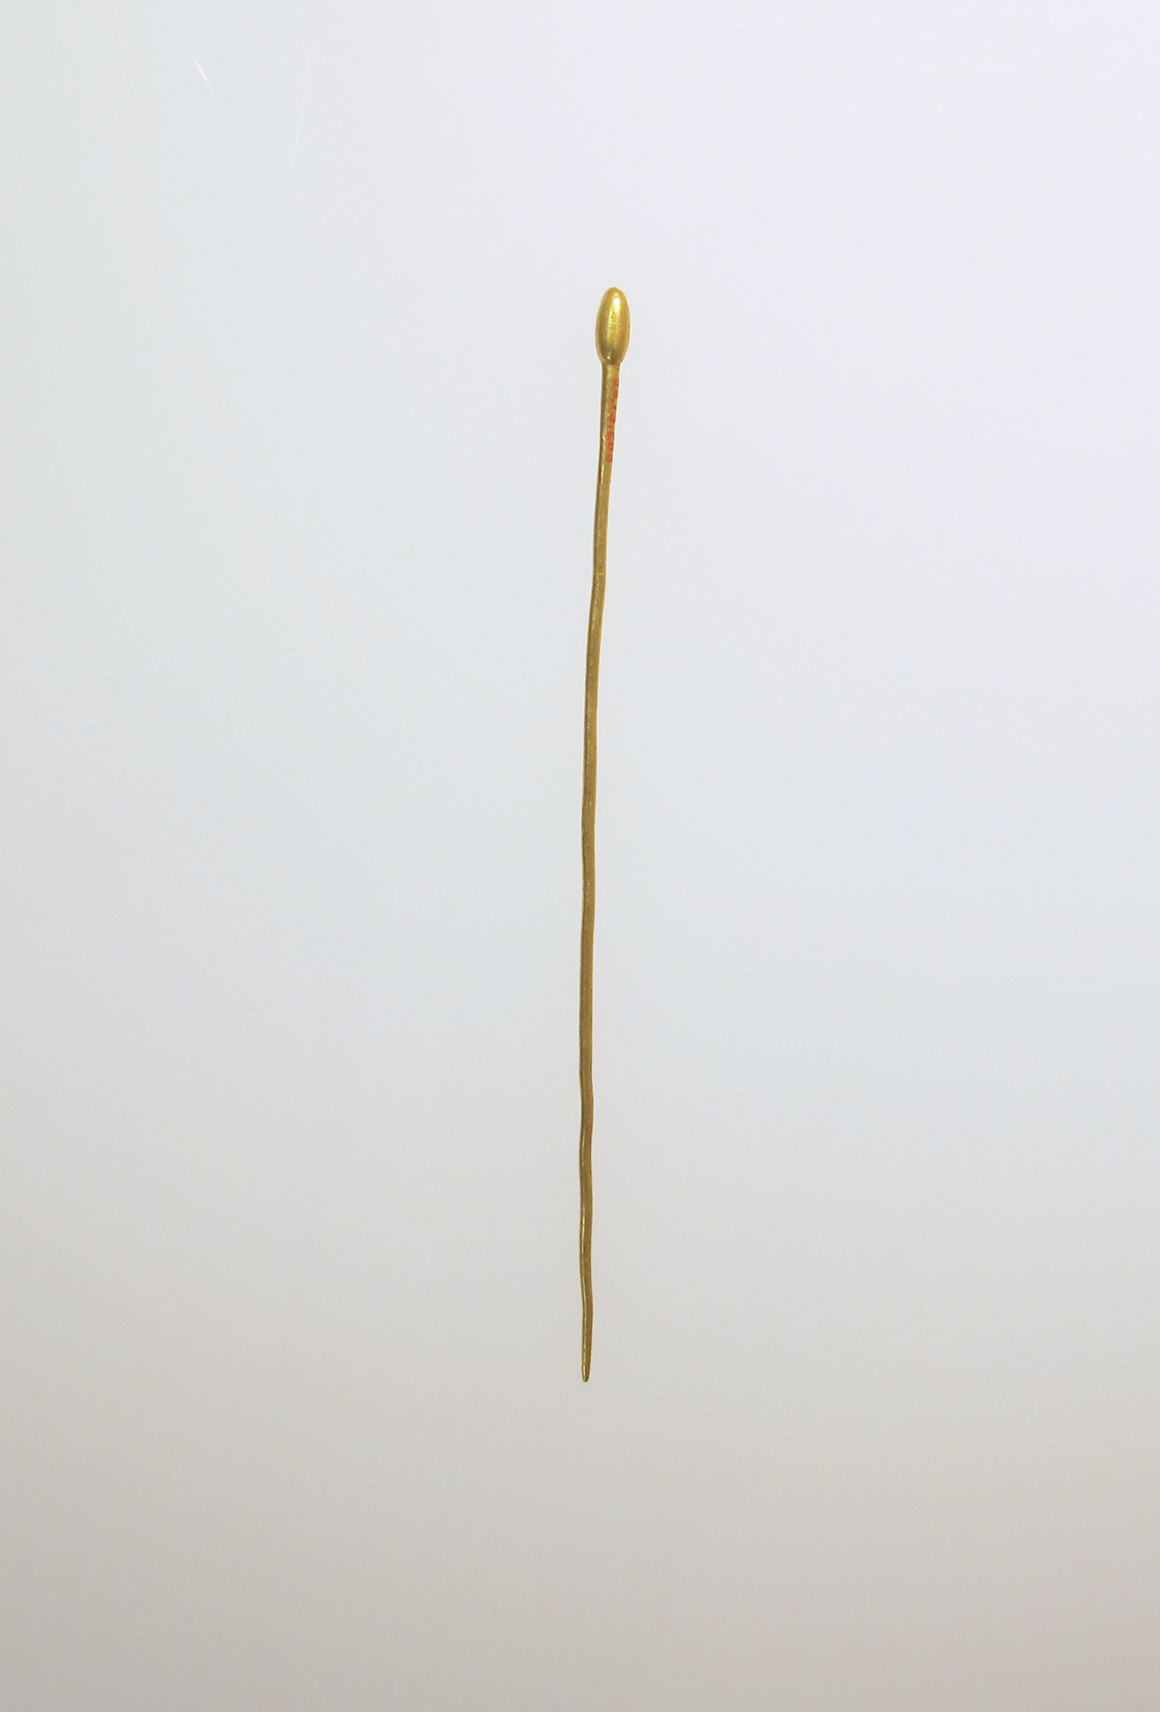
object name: pin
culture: etruscan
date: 900-100 BCE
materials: gold